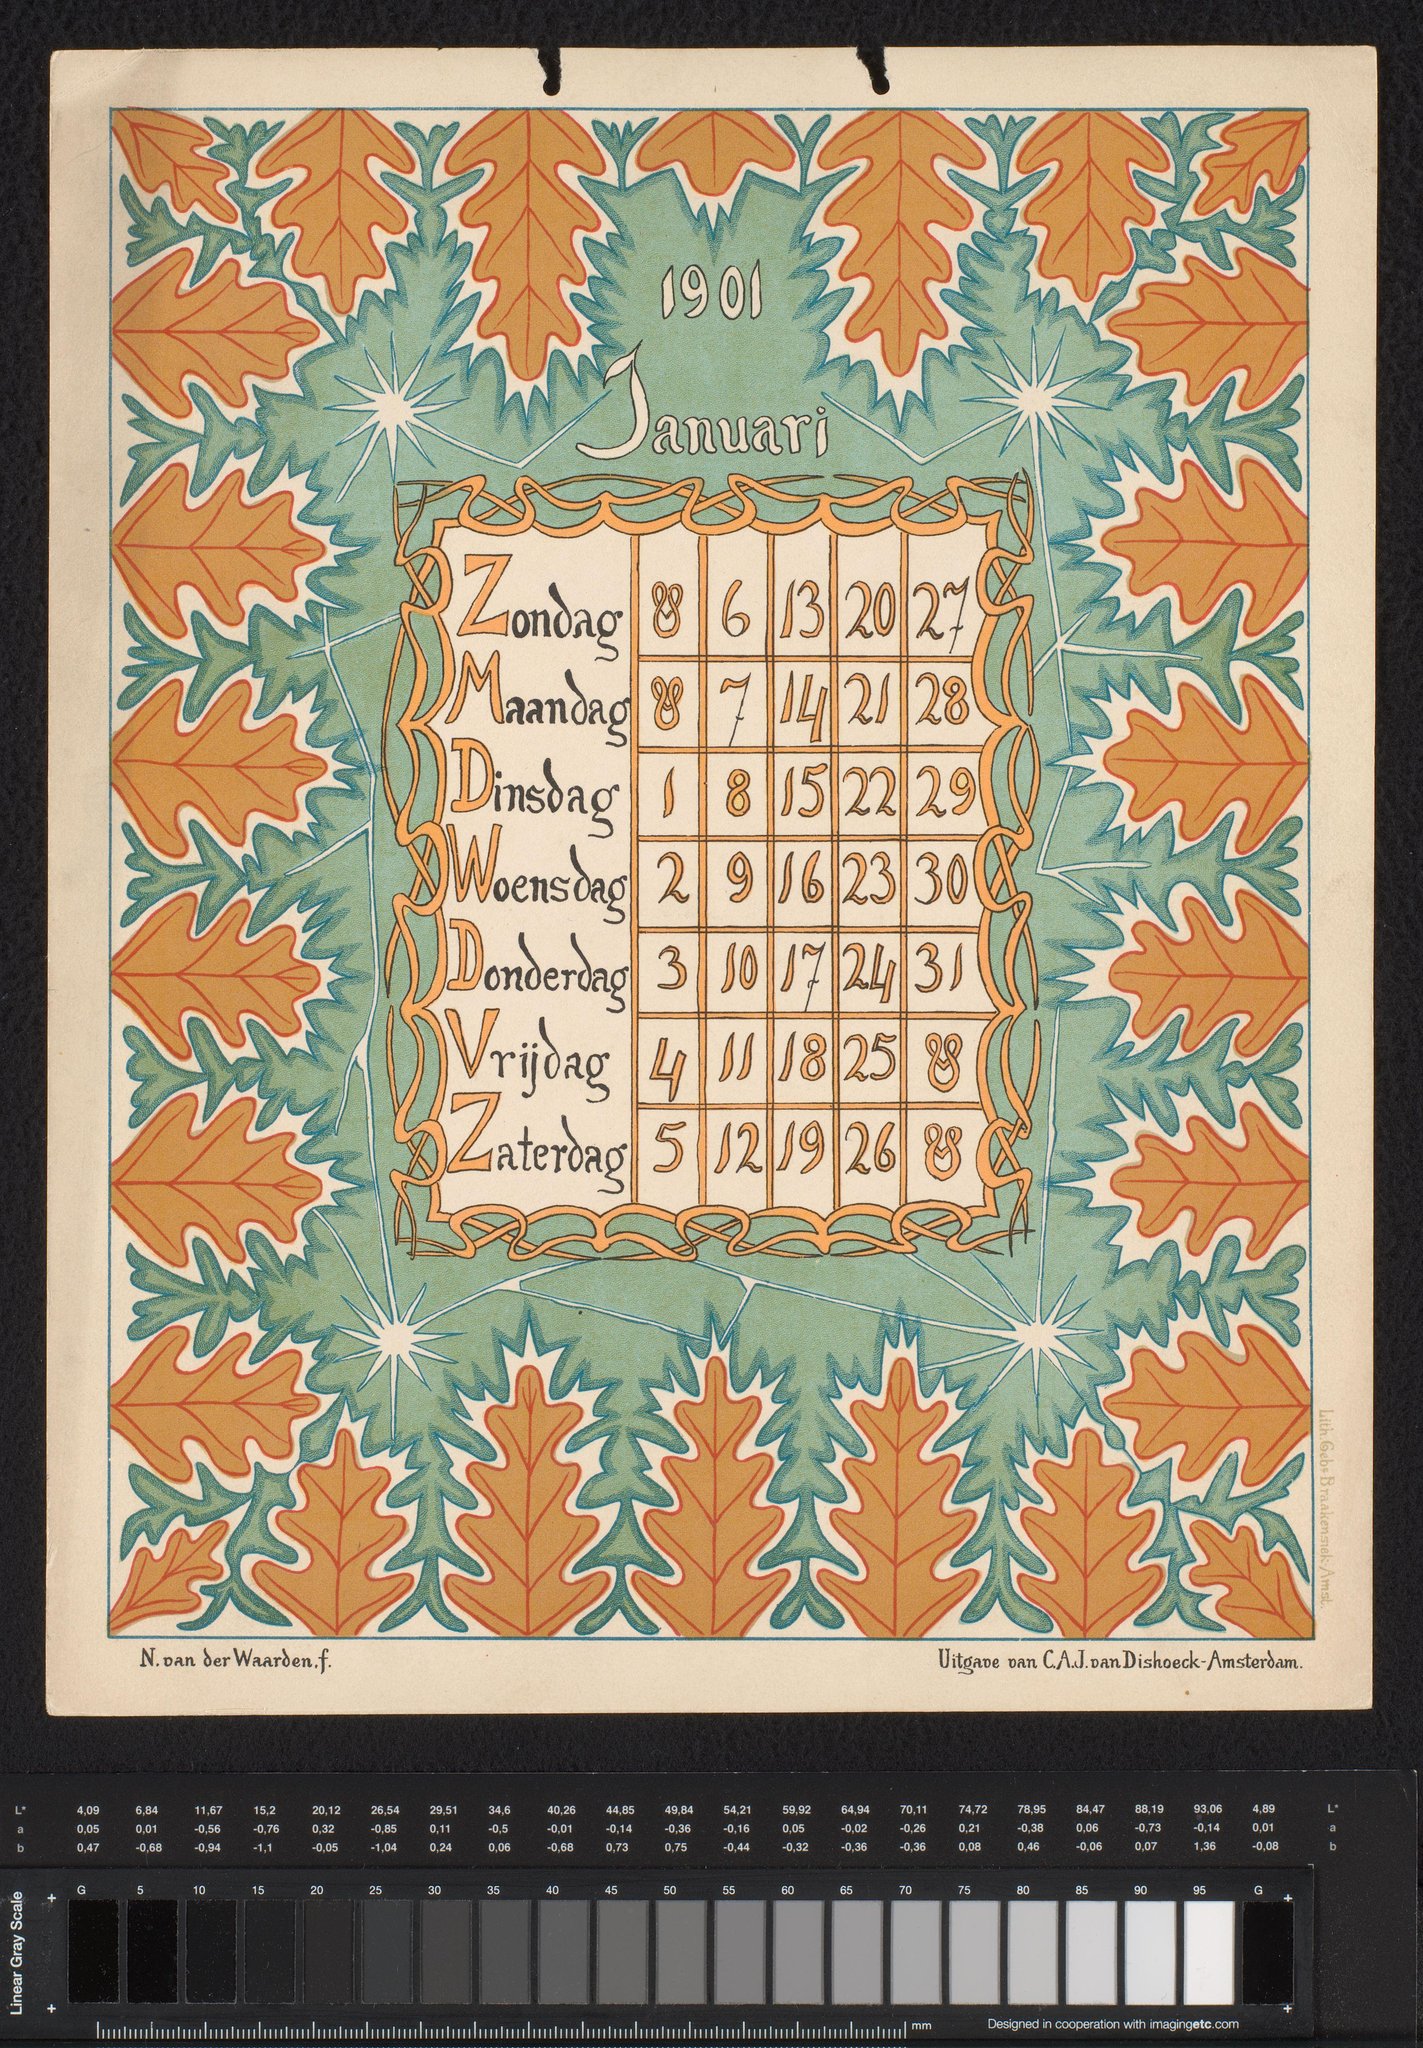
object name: print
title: Kalenderblad voor januari 1901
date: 1900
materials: paper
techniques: lithograph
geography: amsterdam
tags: ornaments ~ art, calendar, almanac, trees: oak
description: Kalenderblad voor januari 1901 van de kalender 'Bloem en Blad', met een randdecoratie van eikenbladeren.